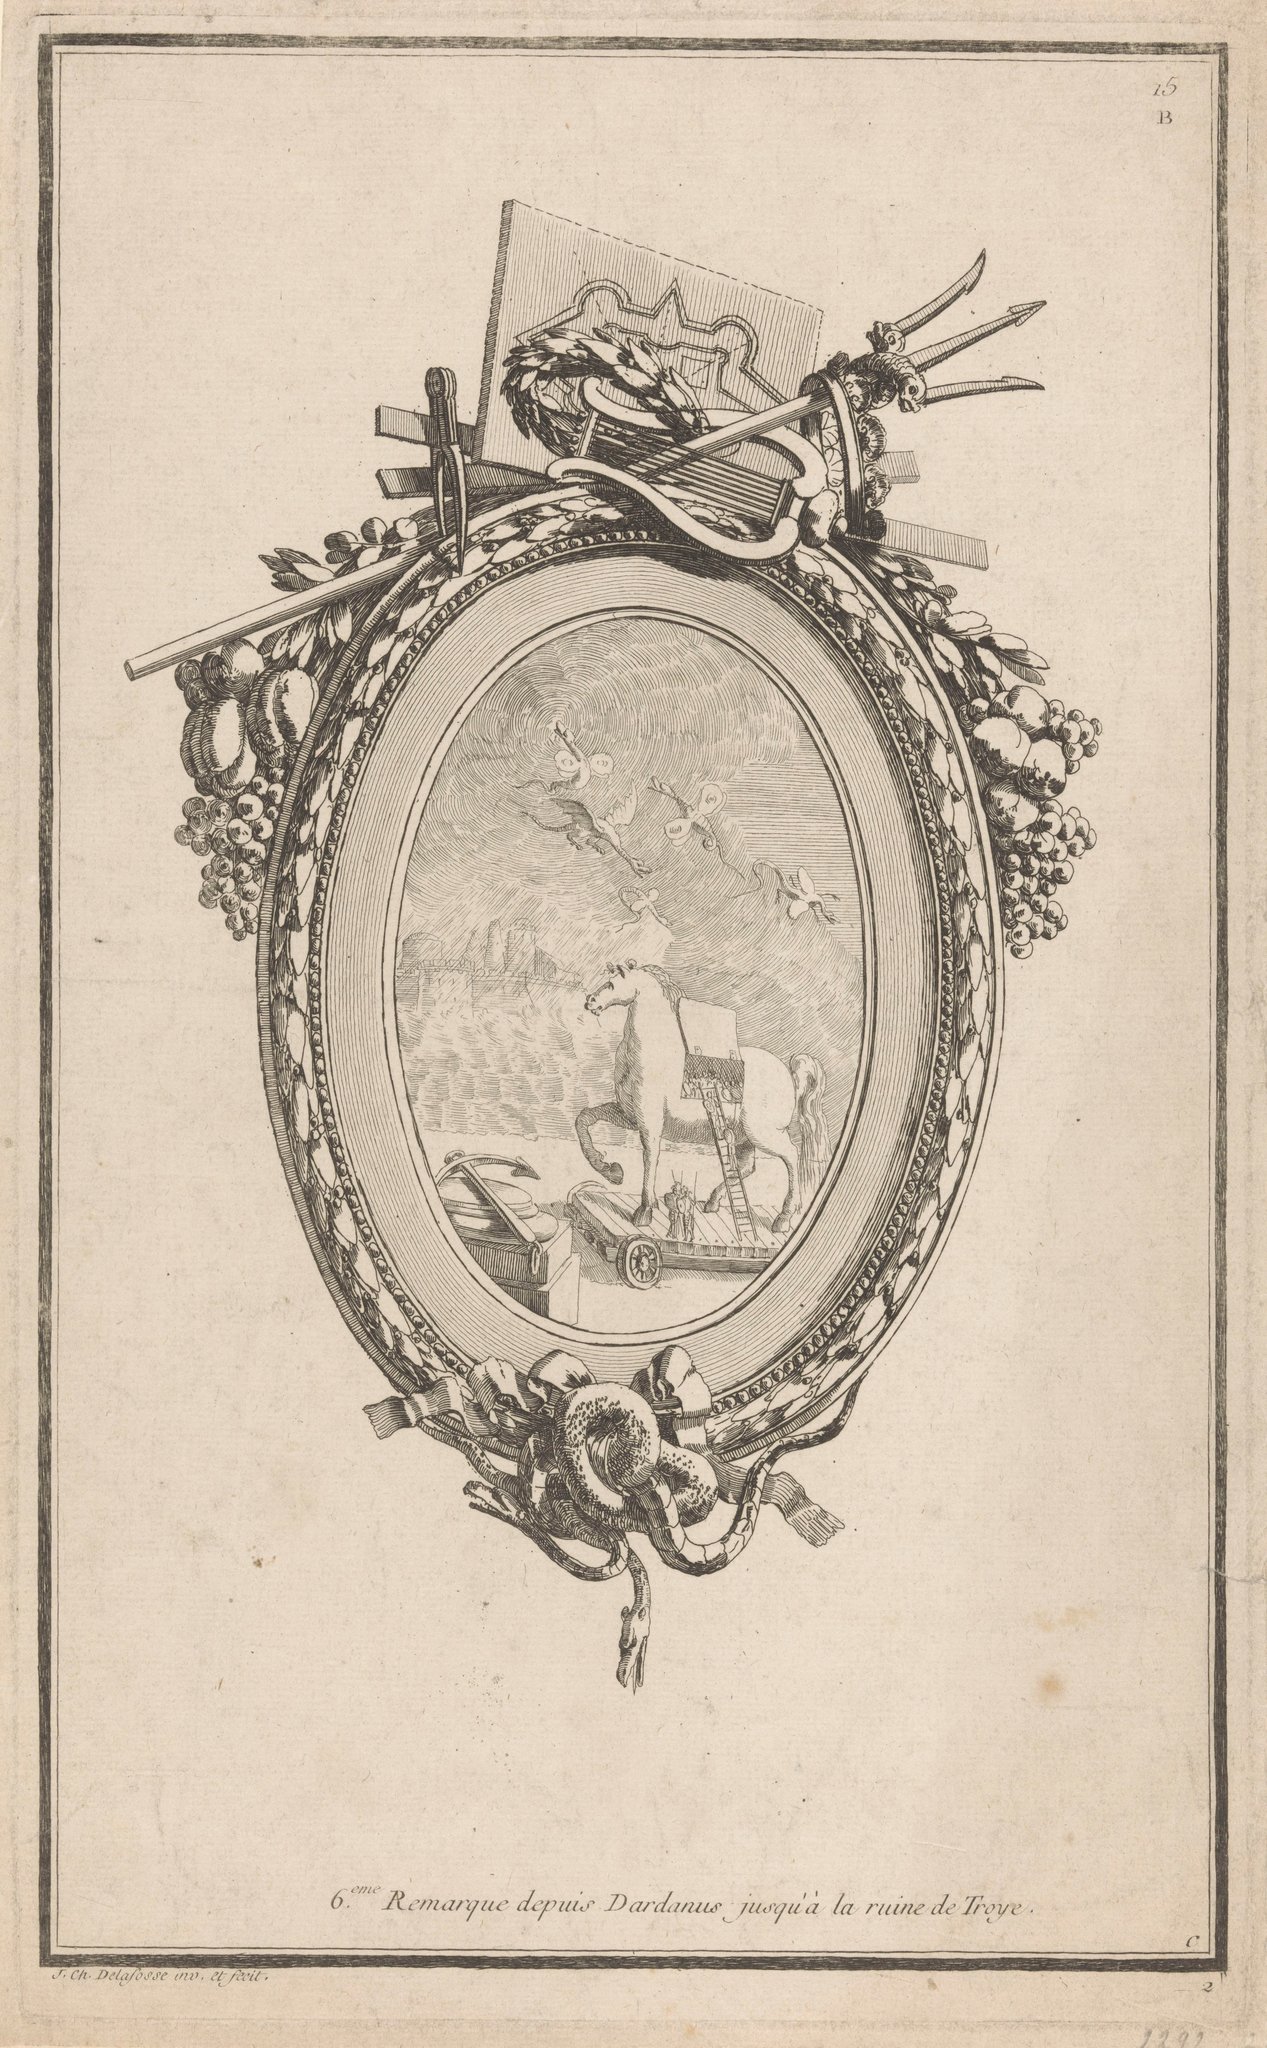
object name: ornament print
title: Nouvelle Iconologie Historique Ou Attributs Hierogliphyques (...)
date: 1768-1771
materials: paper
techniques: etching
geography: paris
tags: the trojan horse, ornament ~ medallion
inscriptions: collector's mark: Lugt 2228, collector's mark: Lugt 2760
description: Een ovaal medaillon met het paard van Troje en de stad in de achtergrond. Prentnummer 15B.